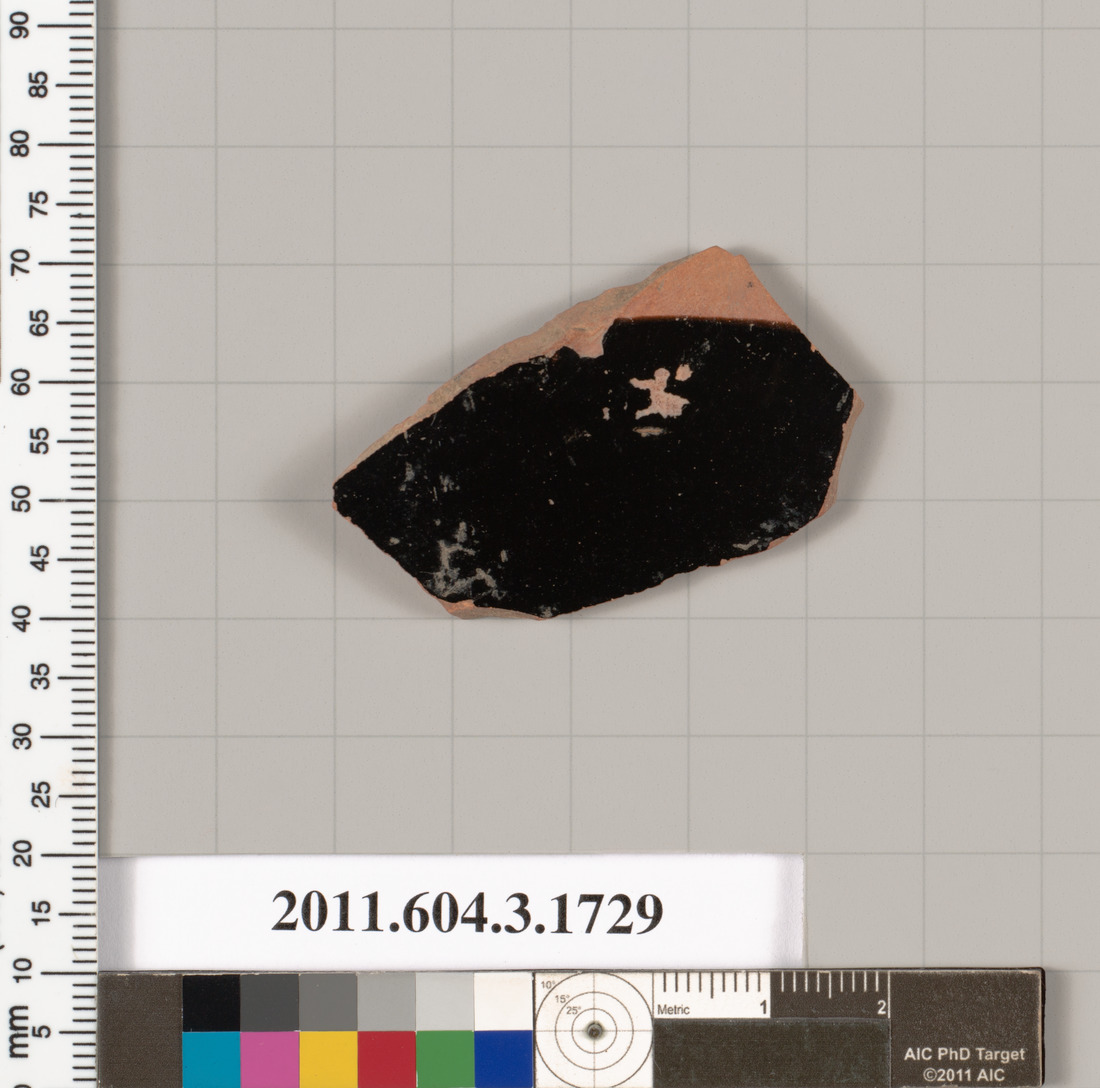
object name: kylix fragment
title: Terracotta fragment of a kylix: Band or lip cup (drinking cup)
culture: greek, attic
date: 550-526 BCE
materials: terracotta